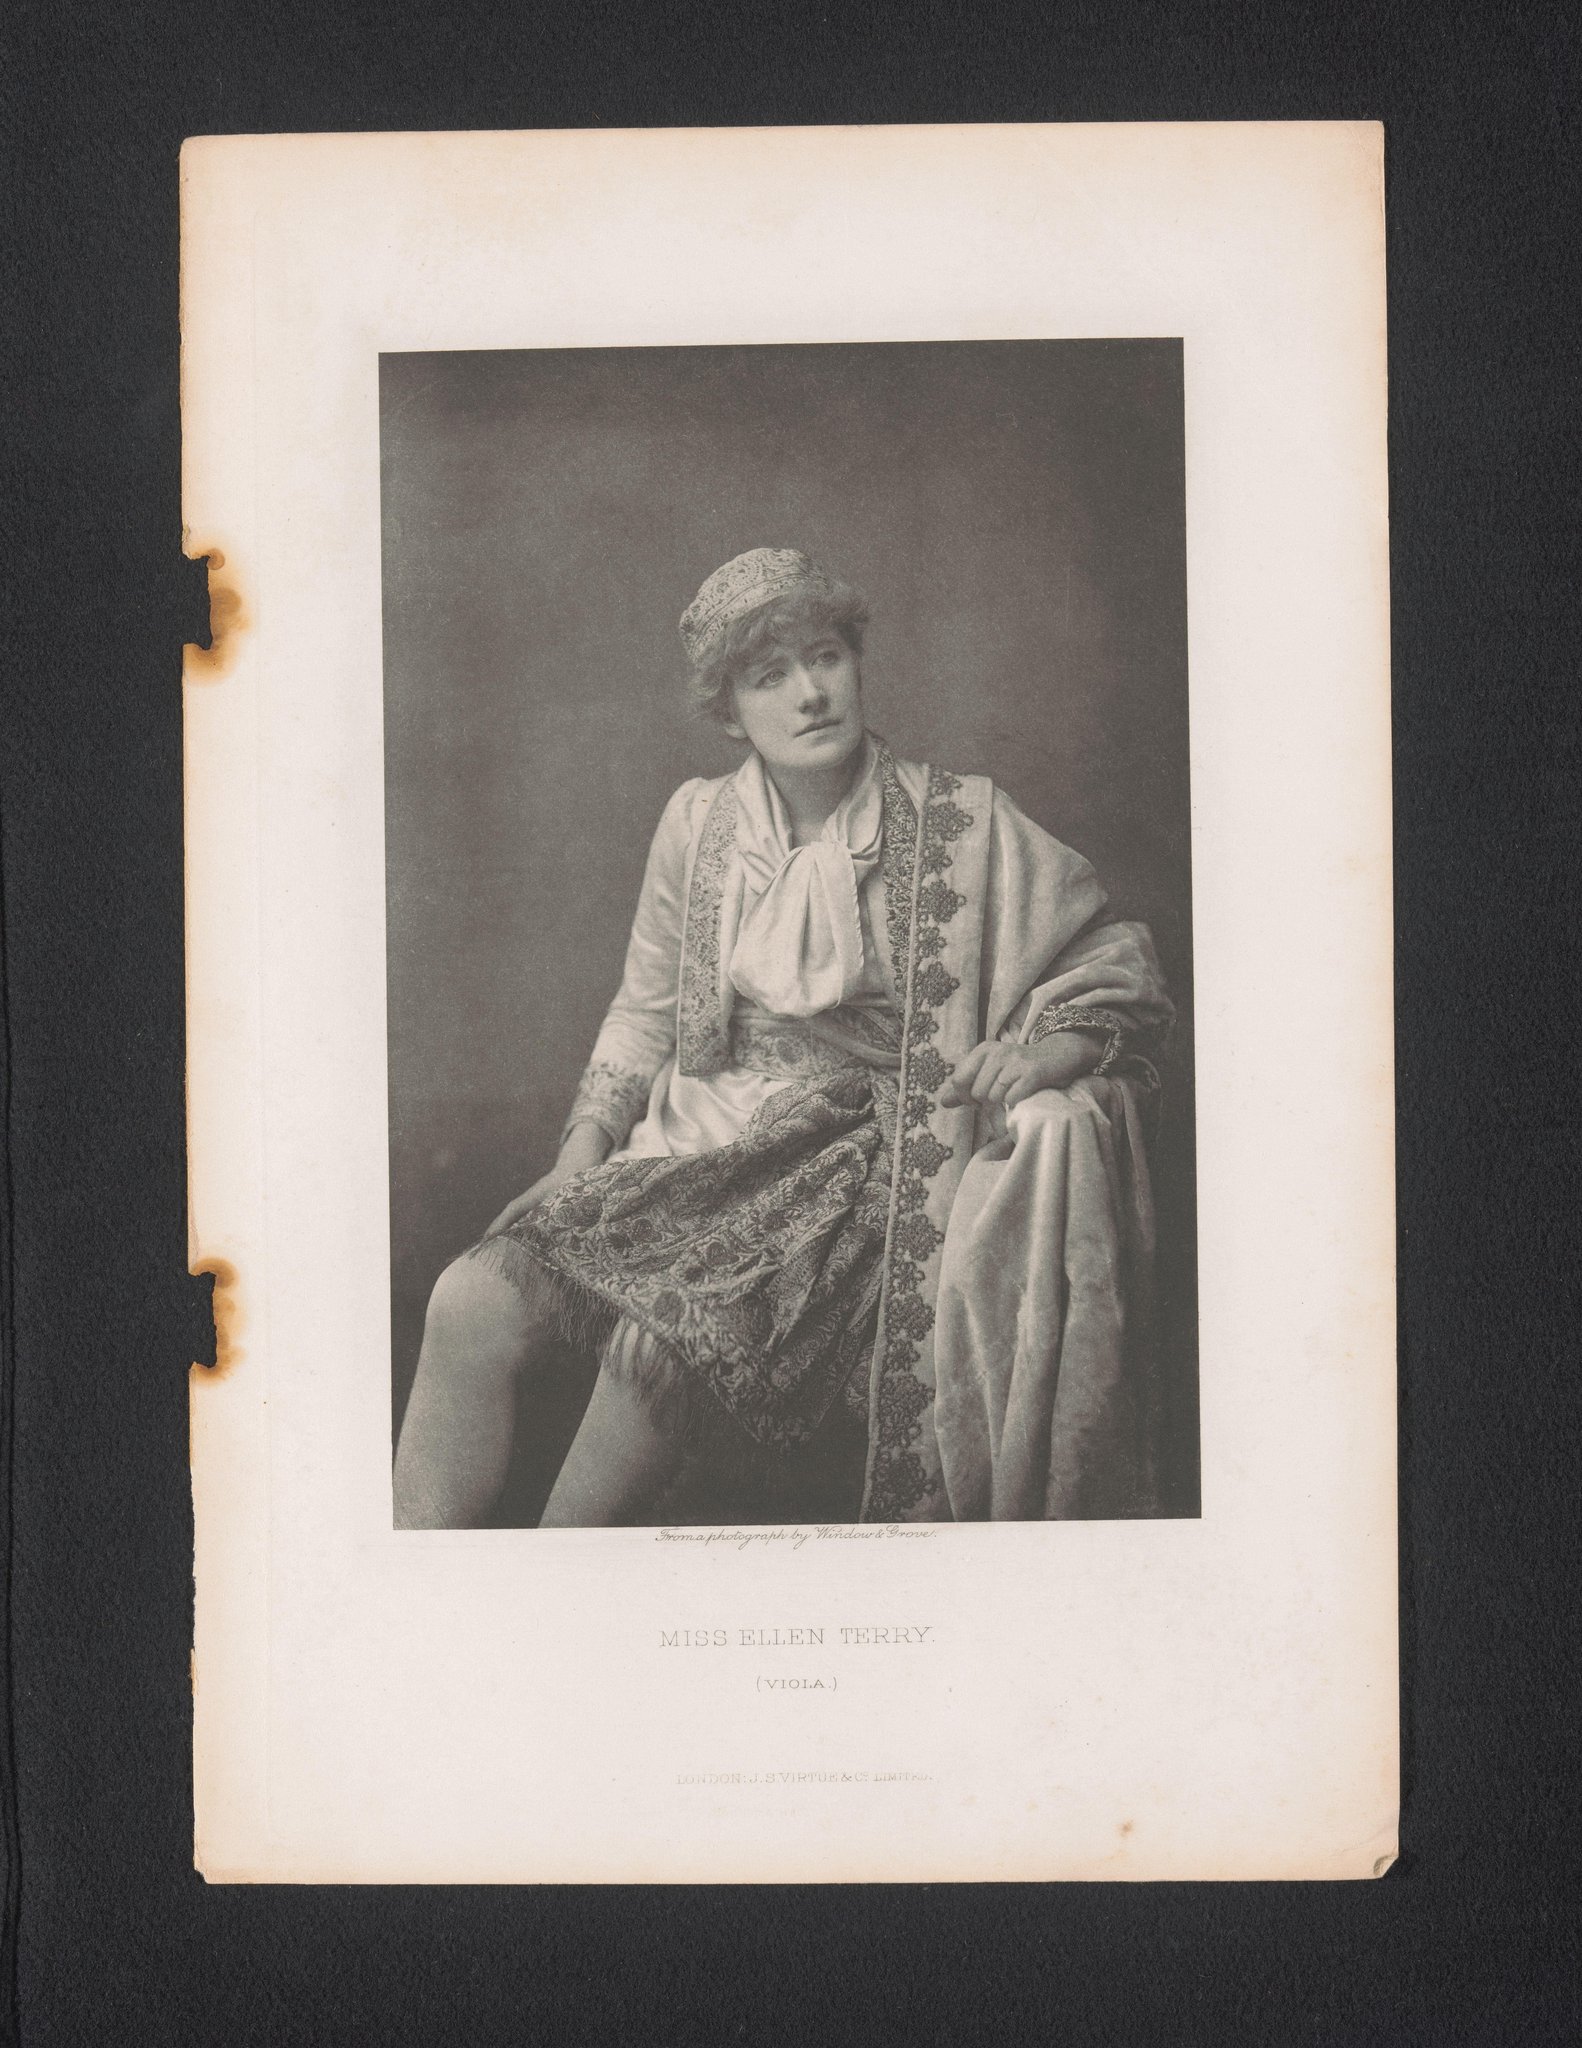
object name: photomechanical print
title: Miss Ellen Terry (Viola)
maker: Anonymous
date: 1880-1890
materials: paper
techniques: photoaquatint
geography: london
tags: portrait of actor, actress